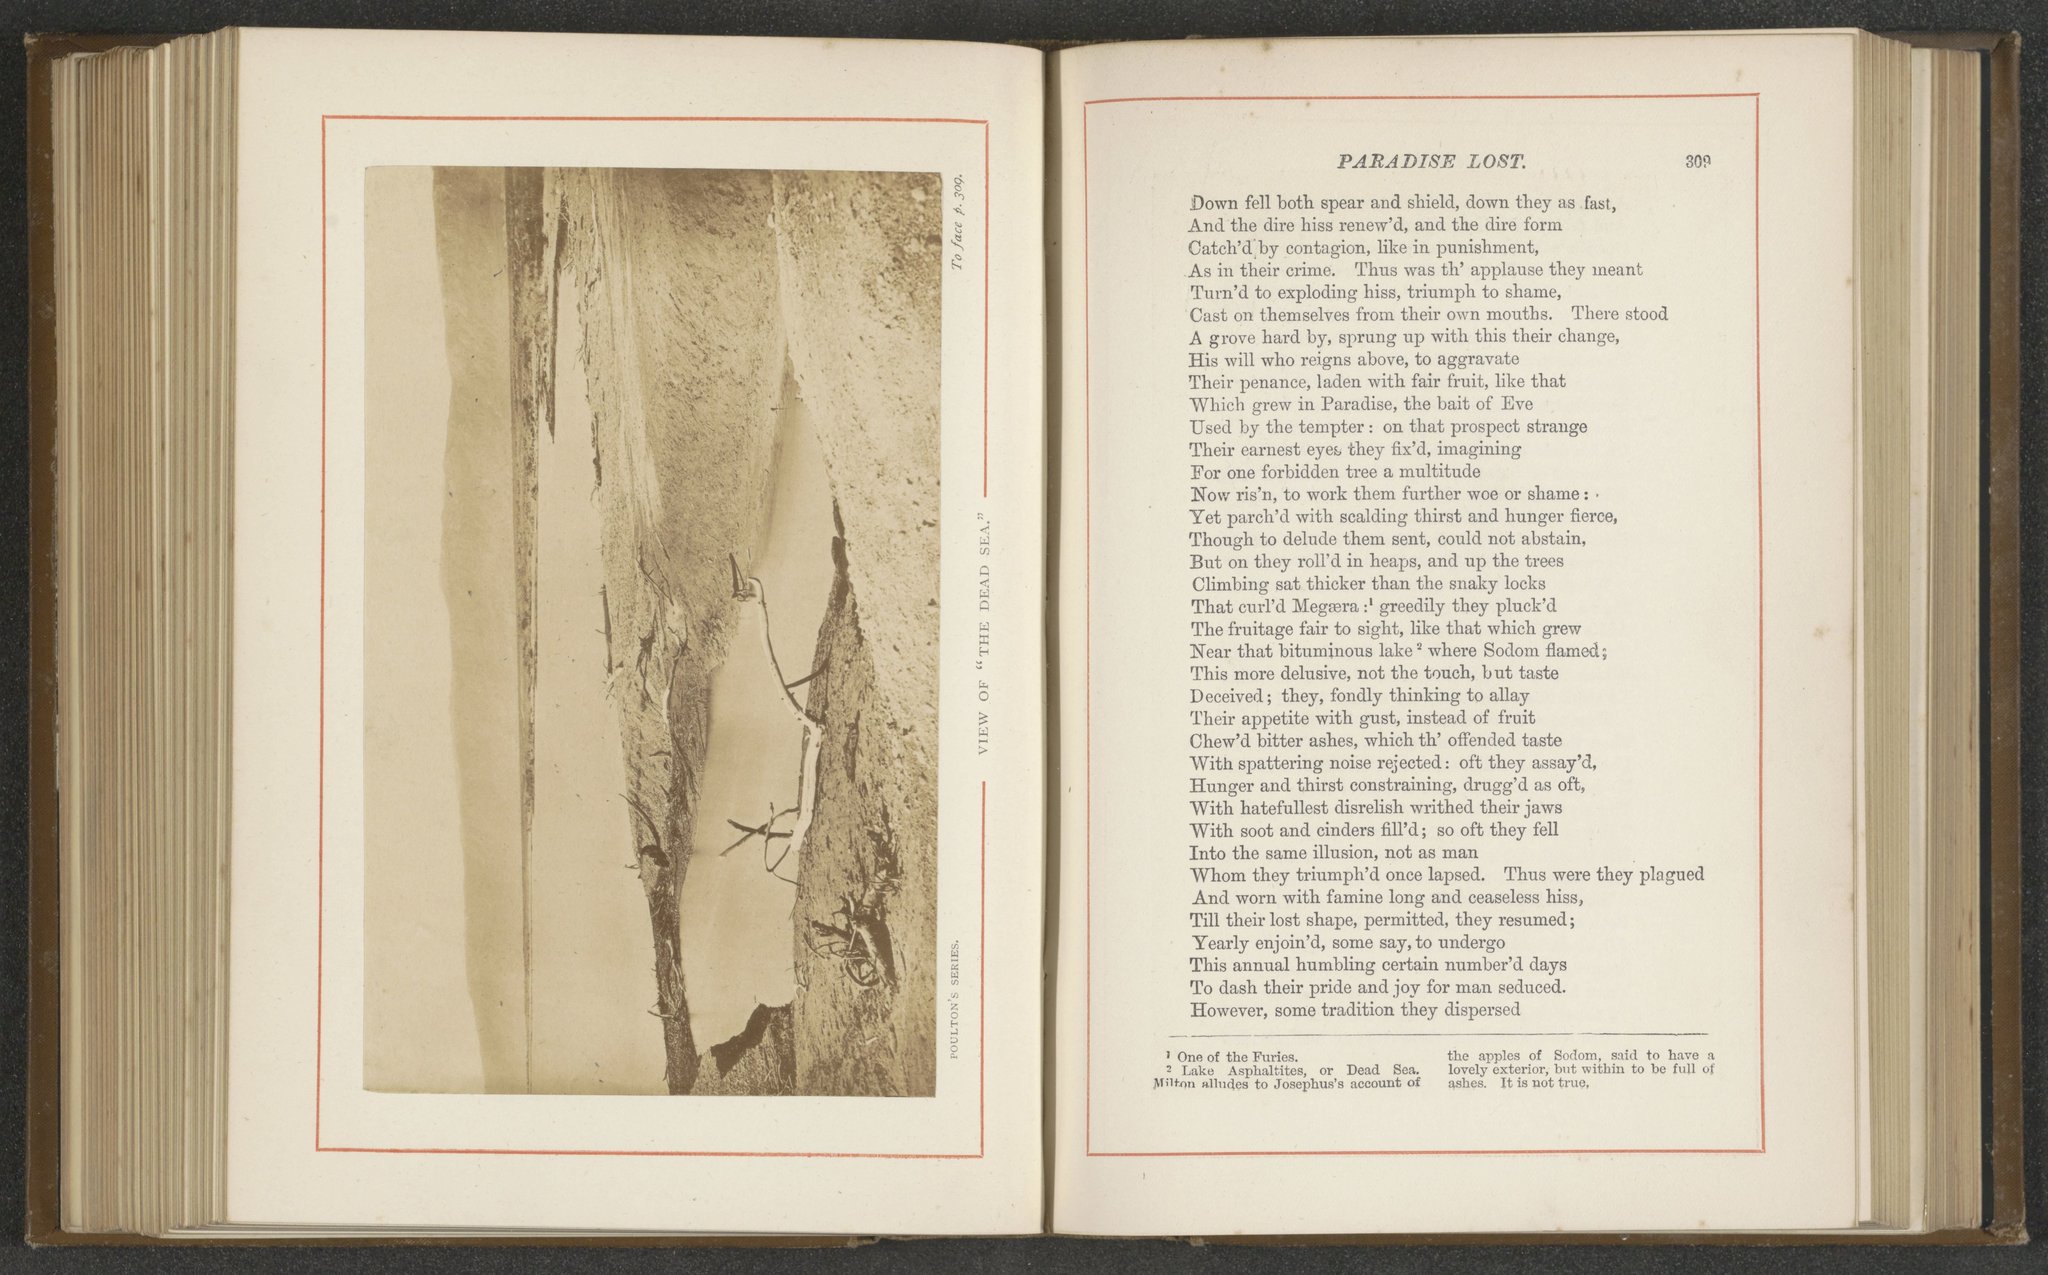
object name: photograph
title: View of “The Dead Sea”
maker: Anonymous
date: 1880-1890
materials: photographic support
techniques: albumen print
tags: rocky coast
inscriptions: inscription: ‘Poulton's Series.’